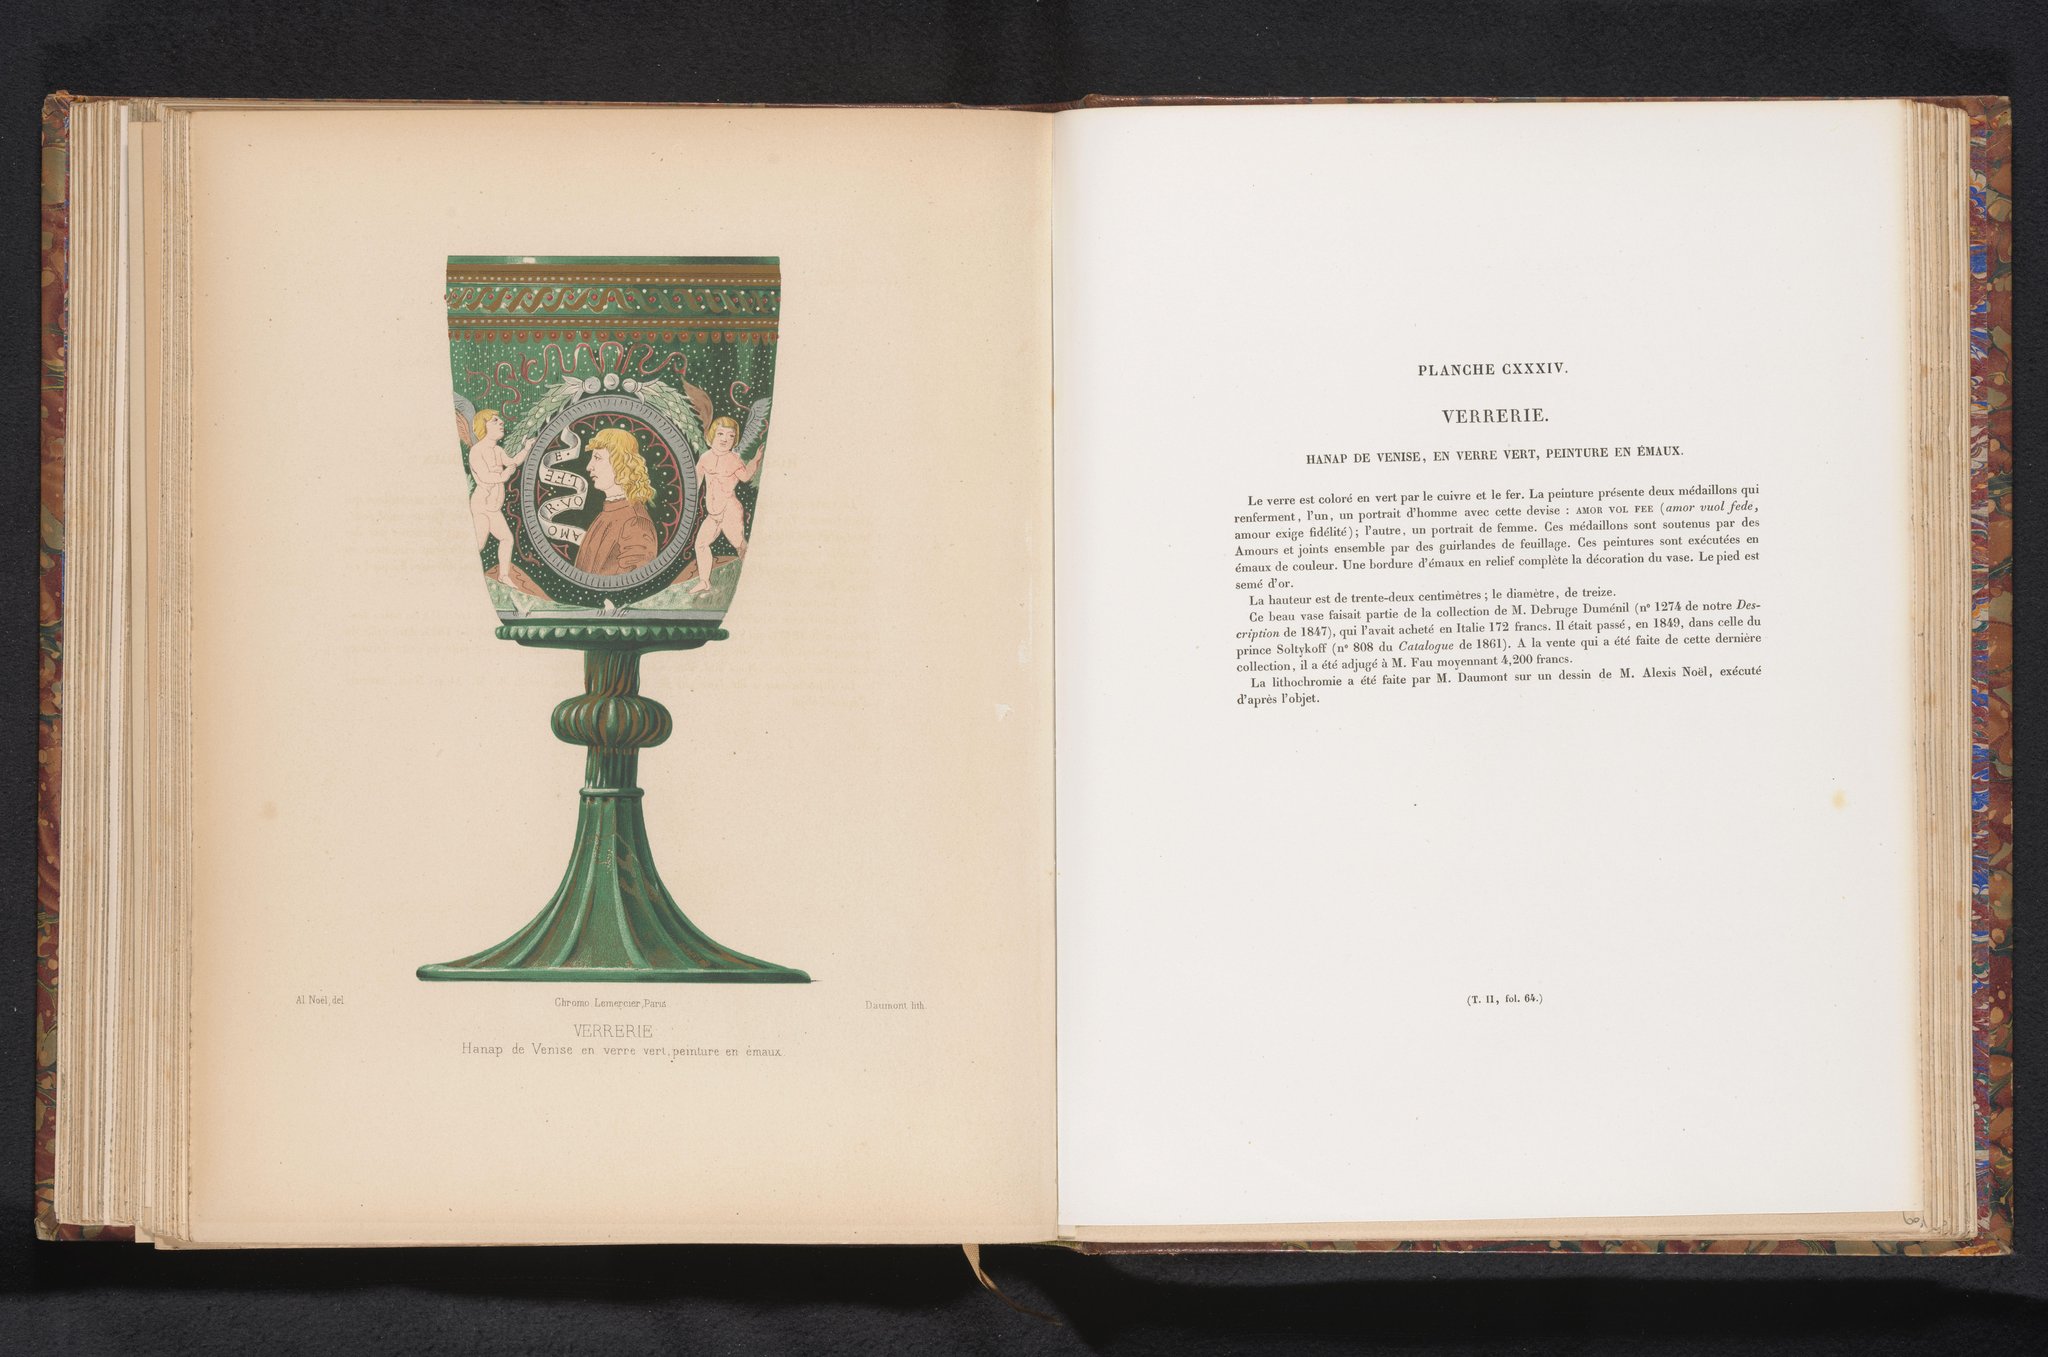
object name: reproduction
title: Reproductie van een ontwerp van een gedecoreerde vaas, voorstellende een vrouw en twee engelen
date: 1859-1864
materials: paper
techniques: chromolithography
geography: paris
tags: container of glass: bottle, jar, vase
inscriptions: name: ‘Al. Noël, del./ Daumont lith.’